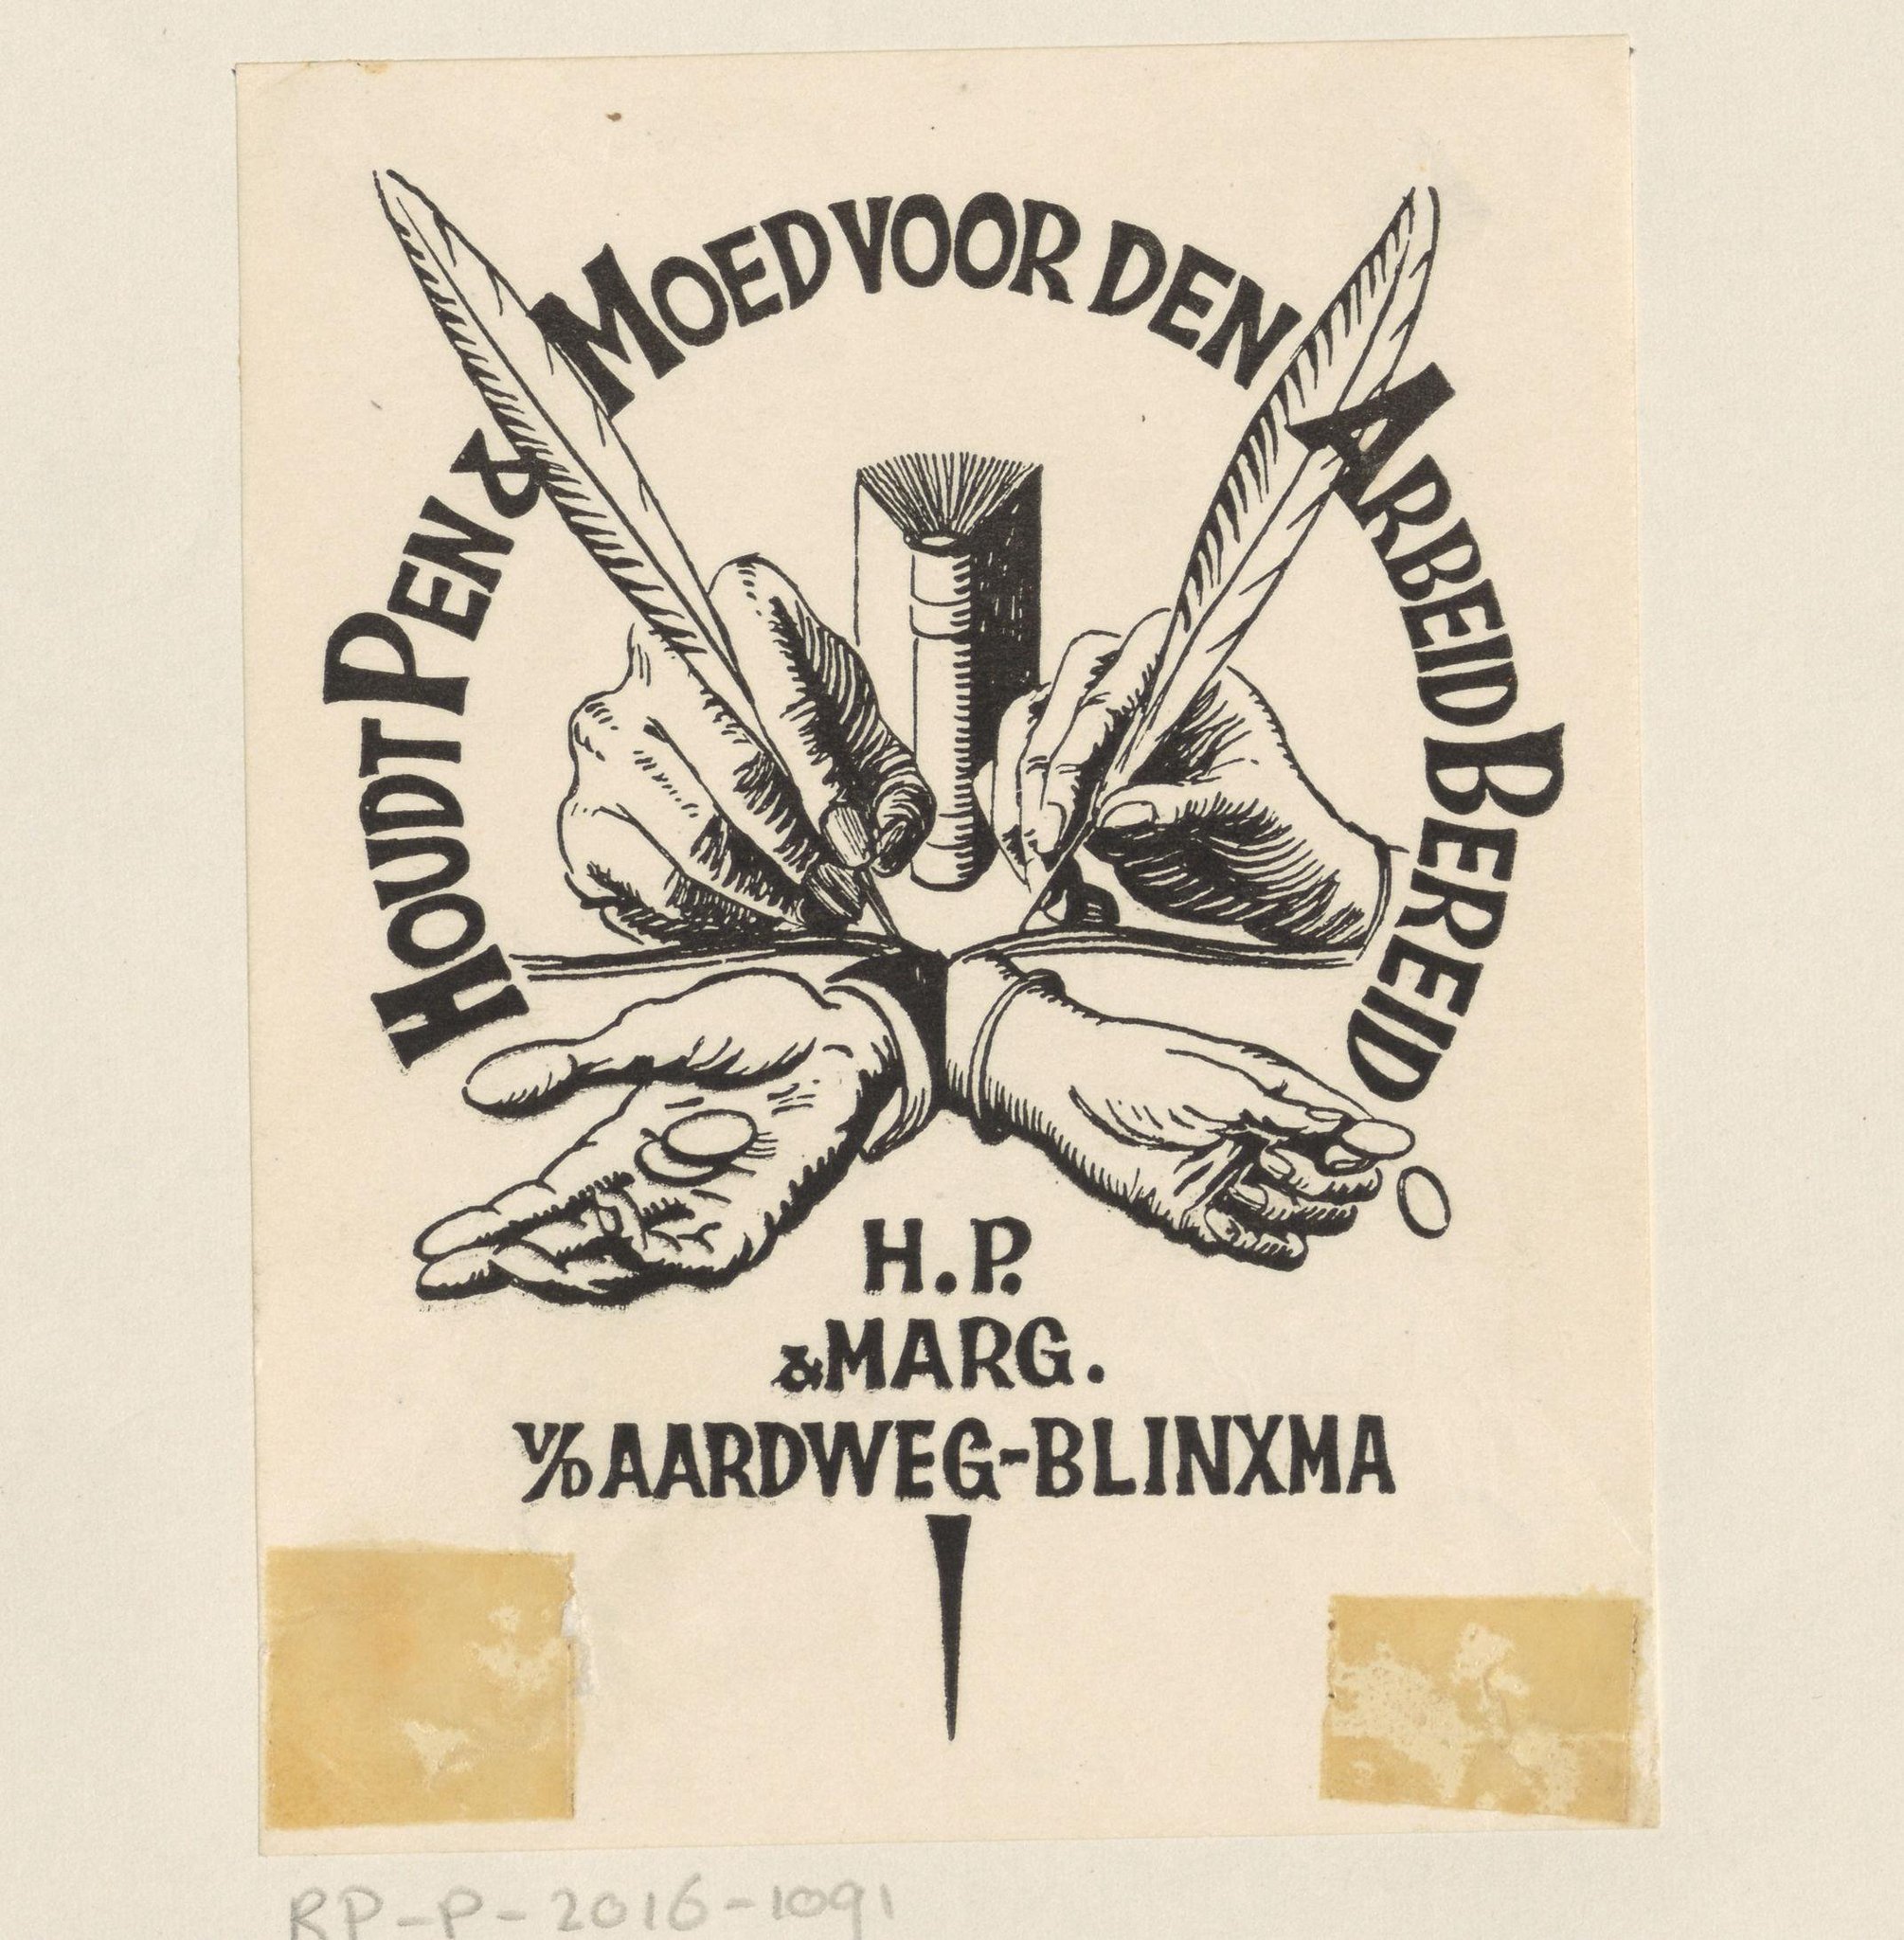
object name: bookplate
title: Ex libris van H.P. & Marg. van den Aardweg-Blinxma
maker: margaretha geertruida van den aardweg-blinxma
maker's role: print maker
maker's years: 1896-1943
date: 1937-1943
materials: paper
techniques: printing block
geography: netherlands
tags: hans p. van den aardweg, amsterdam, margaretha geertruida van den aardweg-blinxma, hand